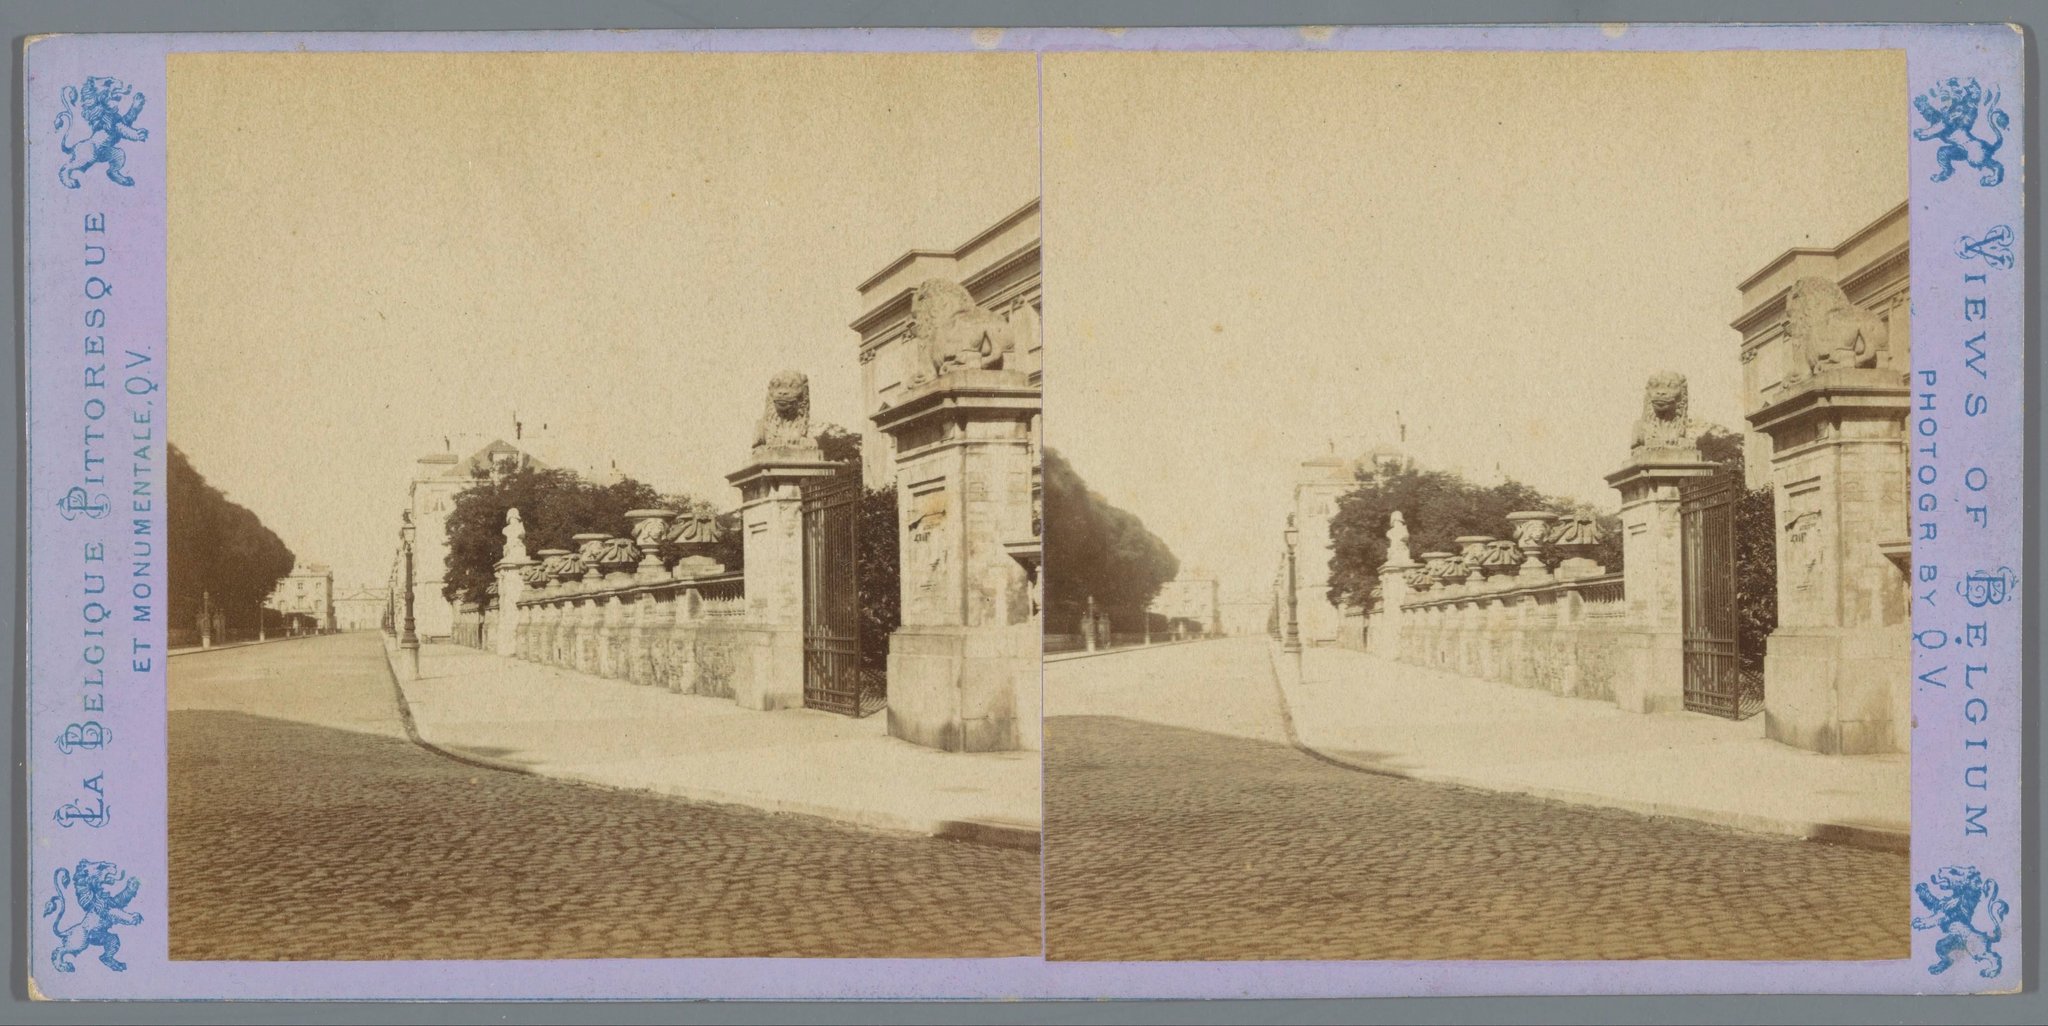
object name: stereograph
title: Bruxelles, la Rue Ducale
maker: jules hippolyte quéval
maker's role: publisher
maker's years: 1824-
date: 1866-1870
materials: cardboard, paper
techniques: albumen print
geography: brussels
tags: gate, entrance, street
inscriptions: number: ‘No 1970’